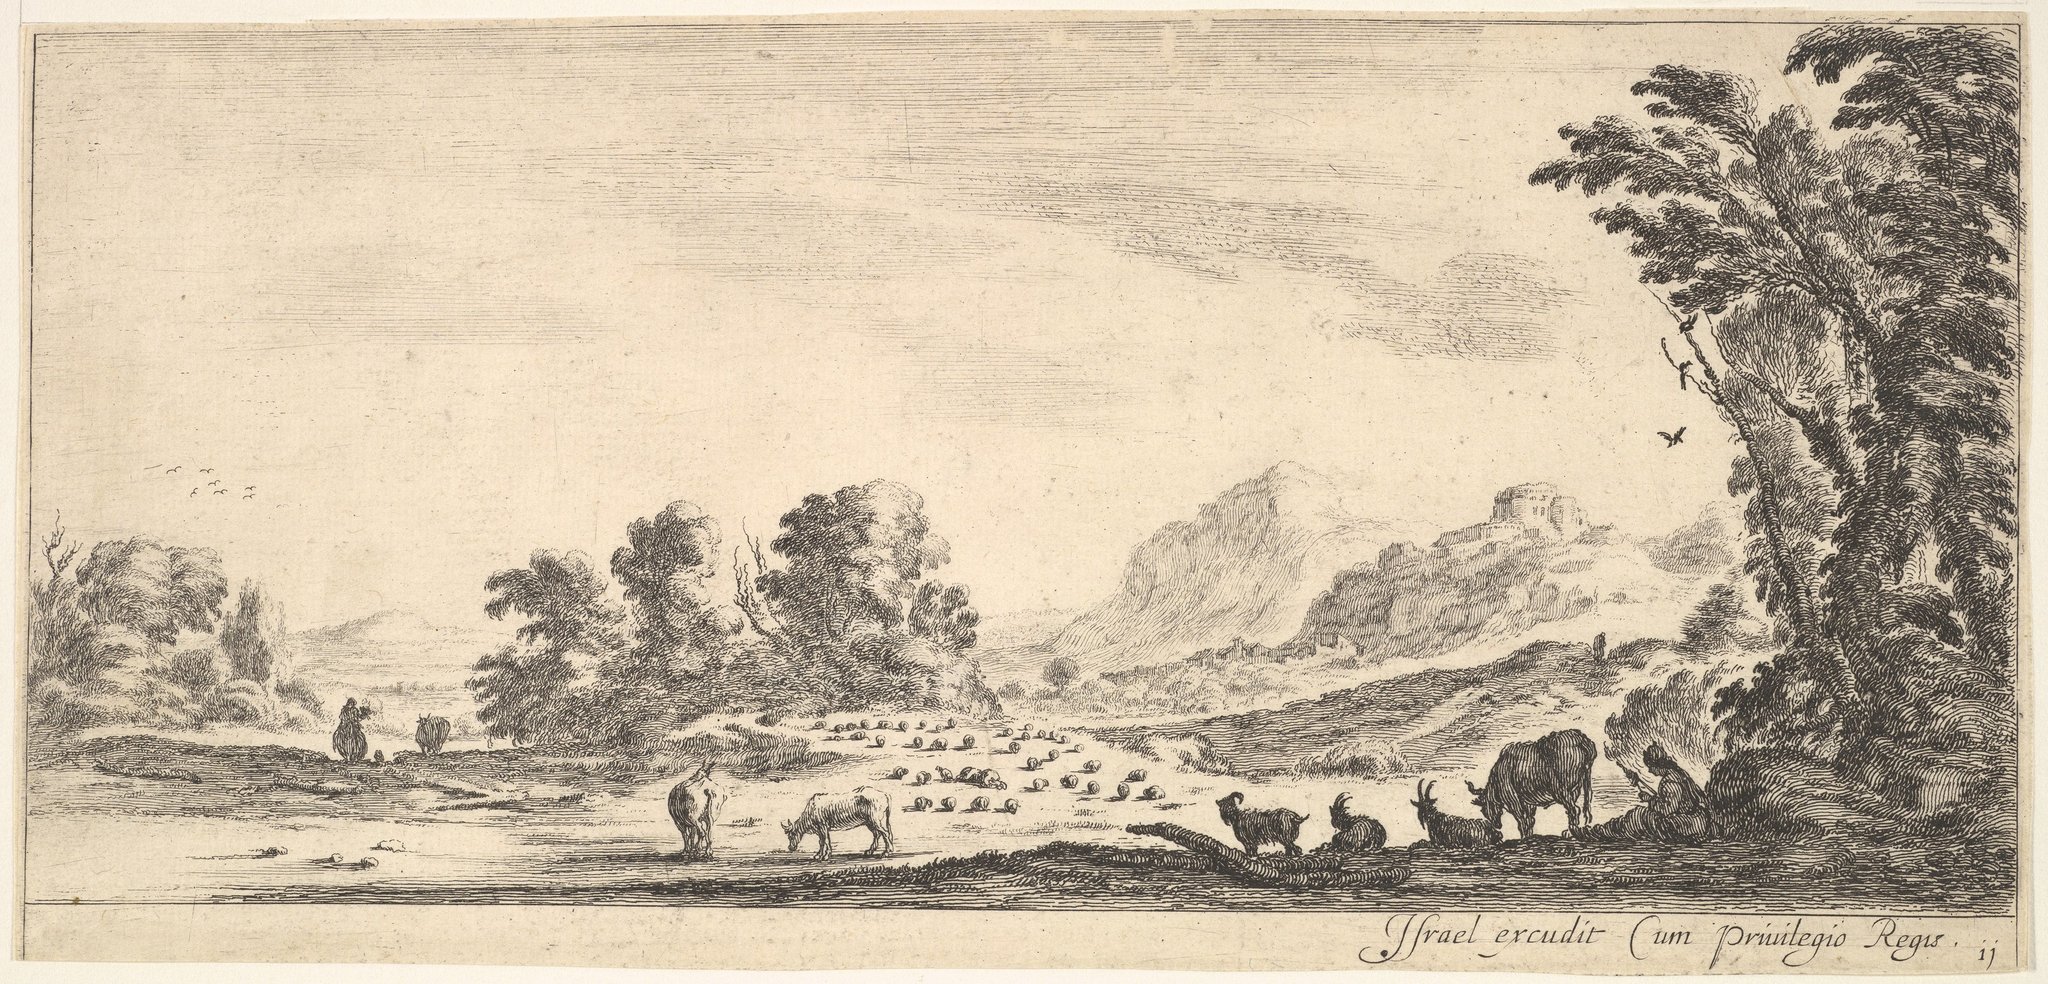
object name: print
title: Plate 11: shepherdess seated to the right under a tree, watching her flock to the left, mountains to right in the background, from "Various Landscapes" (Divers Paysages)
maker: stefano della bella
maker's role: artist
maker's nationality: italian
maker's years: 1610-1664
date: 1641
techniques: etching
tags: animals,women,mountains,landscapes,shepherds